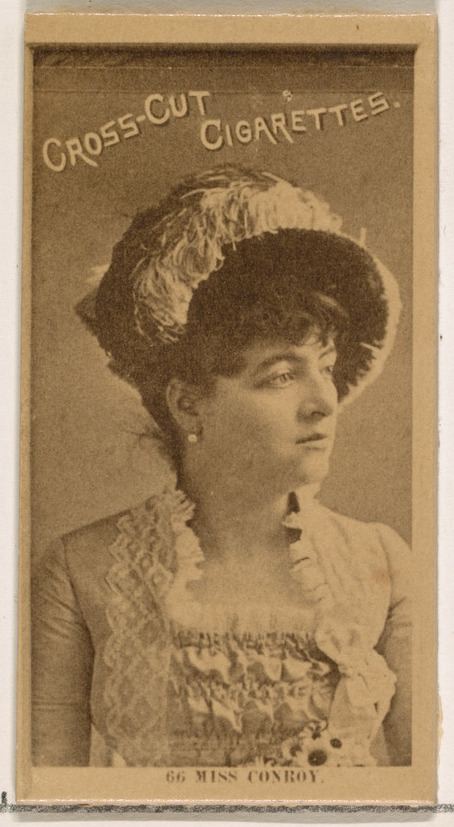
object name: print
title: Card Number 66, Miss Conroy, from the Actors and Actresses series (N145-2) issued by Duke Sons & Co. to promote Cross Cut Cigarettes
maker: w. duke, sons & co.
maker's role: publisher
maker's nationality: american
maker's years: 1870-1920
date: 1880-1889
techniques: albumen silver print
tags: portraits,women,actresses